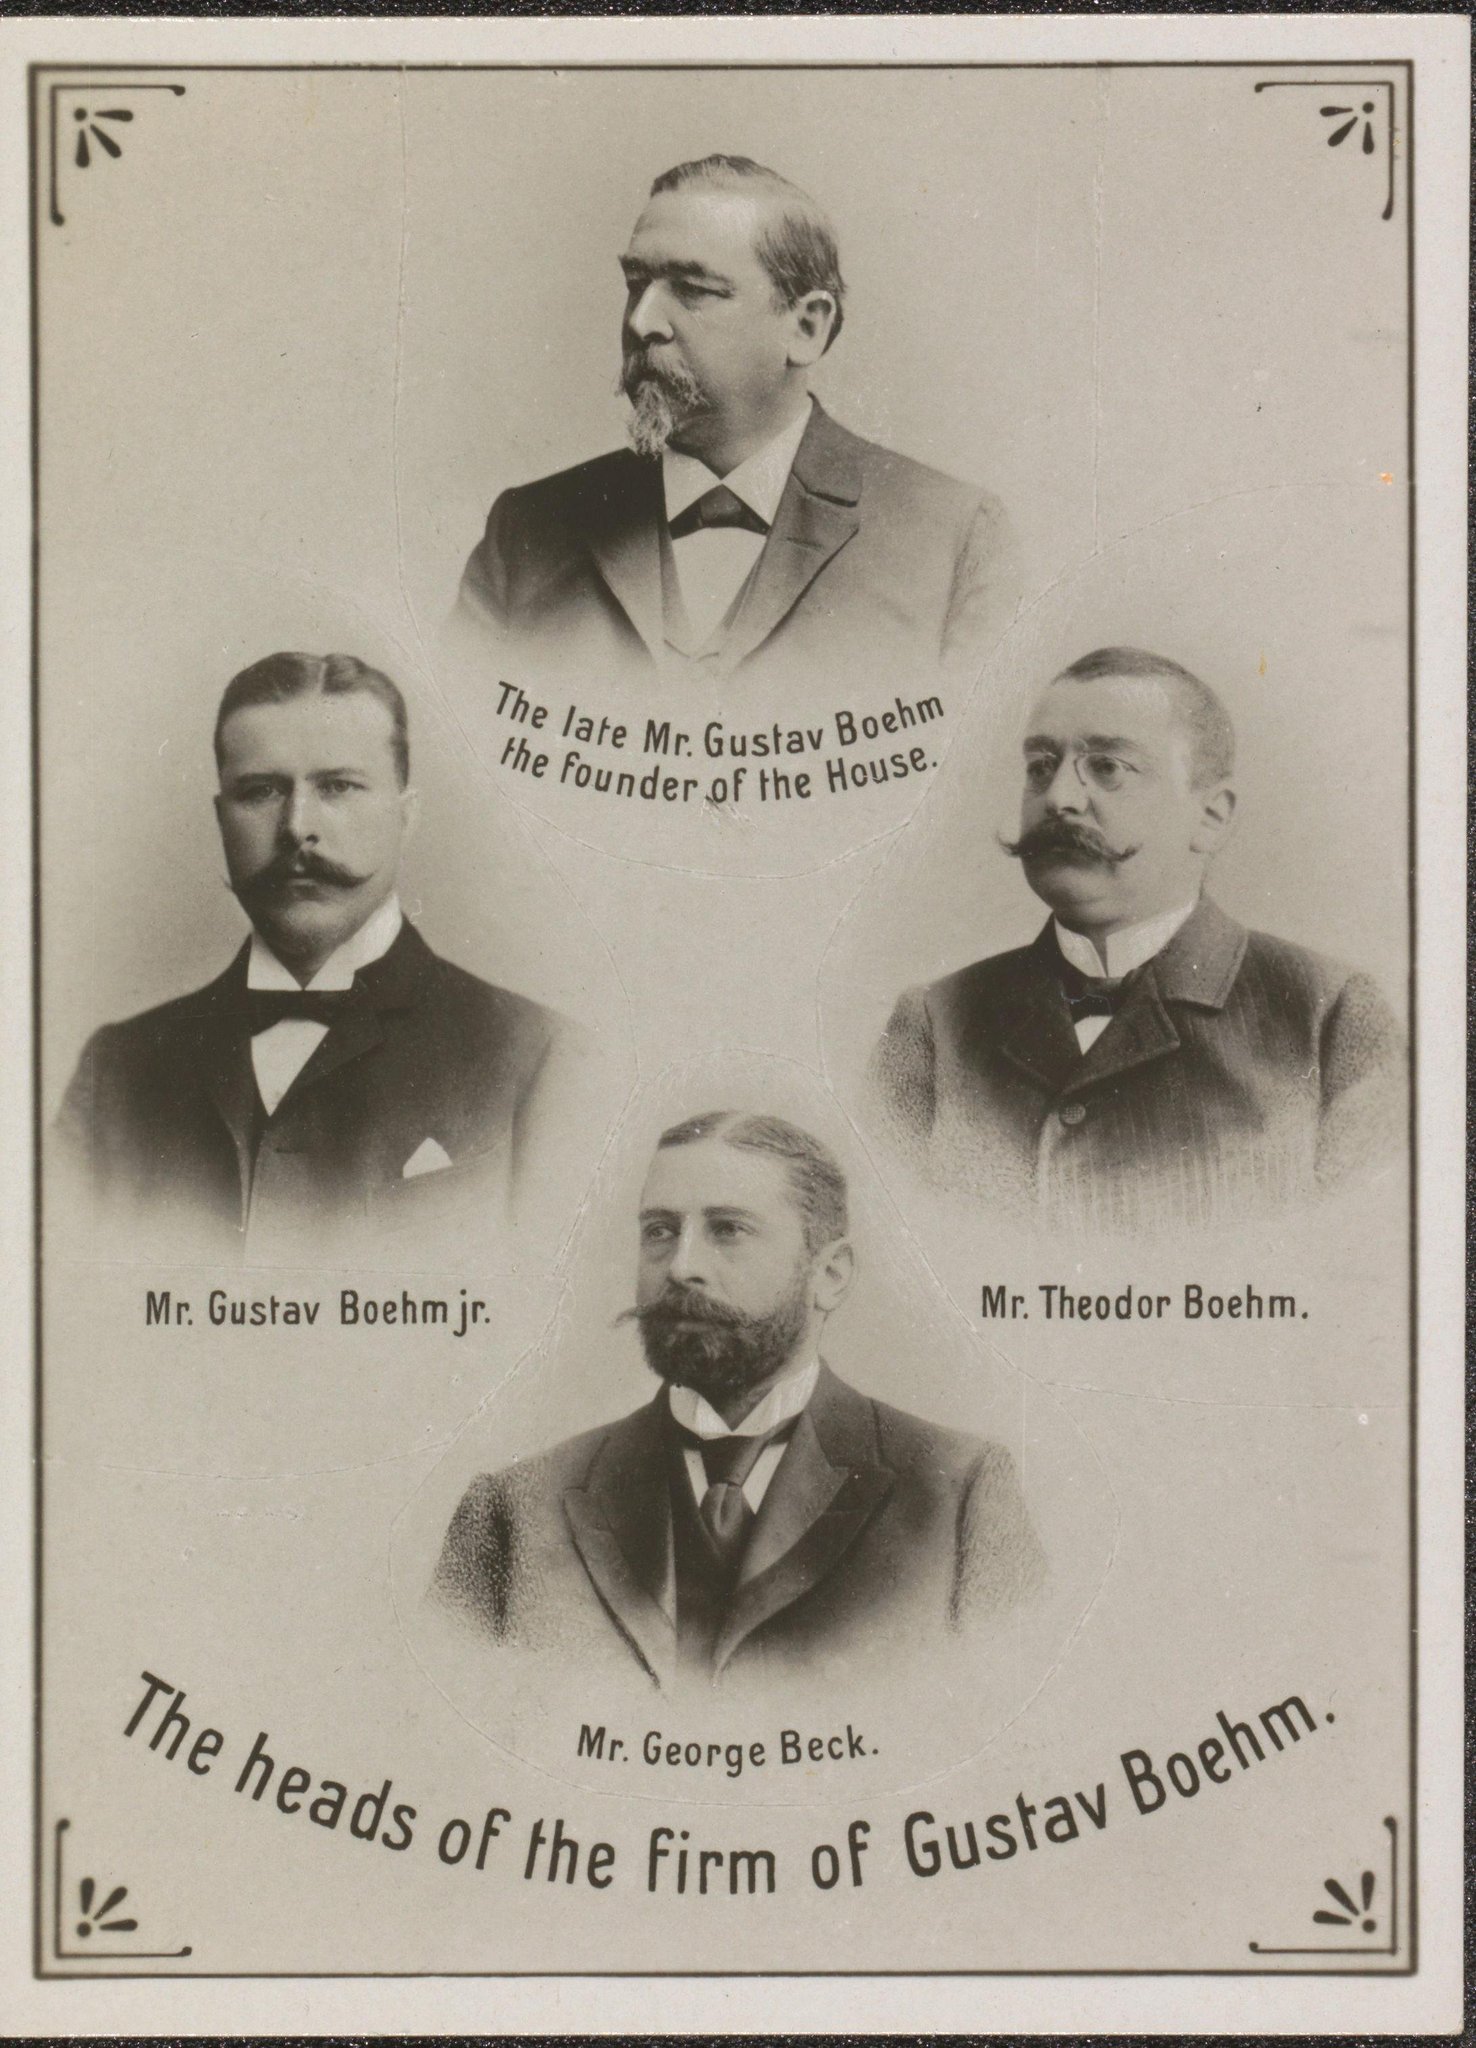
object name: photomontage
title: Fotomontage van de directieleden van de firma van Gustav Boehm: grondlegger wijlen Gustav Boehm sr., Gustav Boehm jr., Theodor Boehm en George Beck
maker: Anonymous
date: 1899-1901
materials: paper, photographic support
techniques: gelatin silver print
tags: gustav boehm (junior), director, boss (in modern industry)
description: Onderdeel van Foto's van de wereldreis van Gustav Boehm 1899-1901, serie 1.